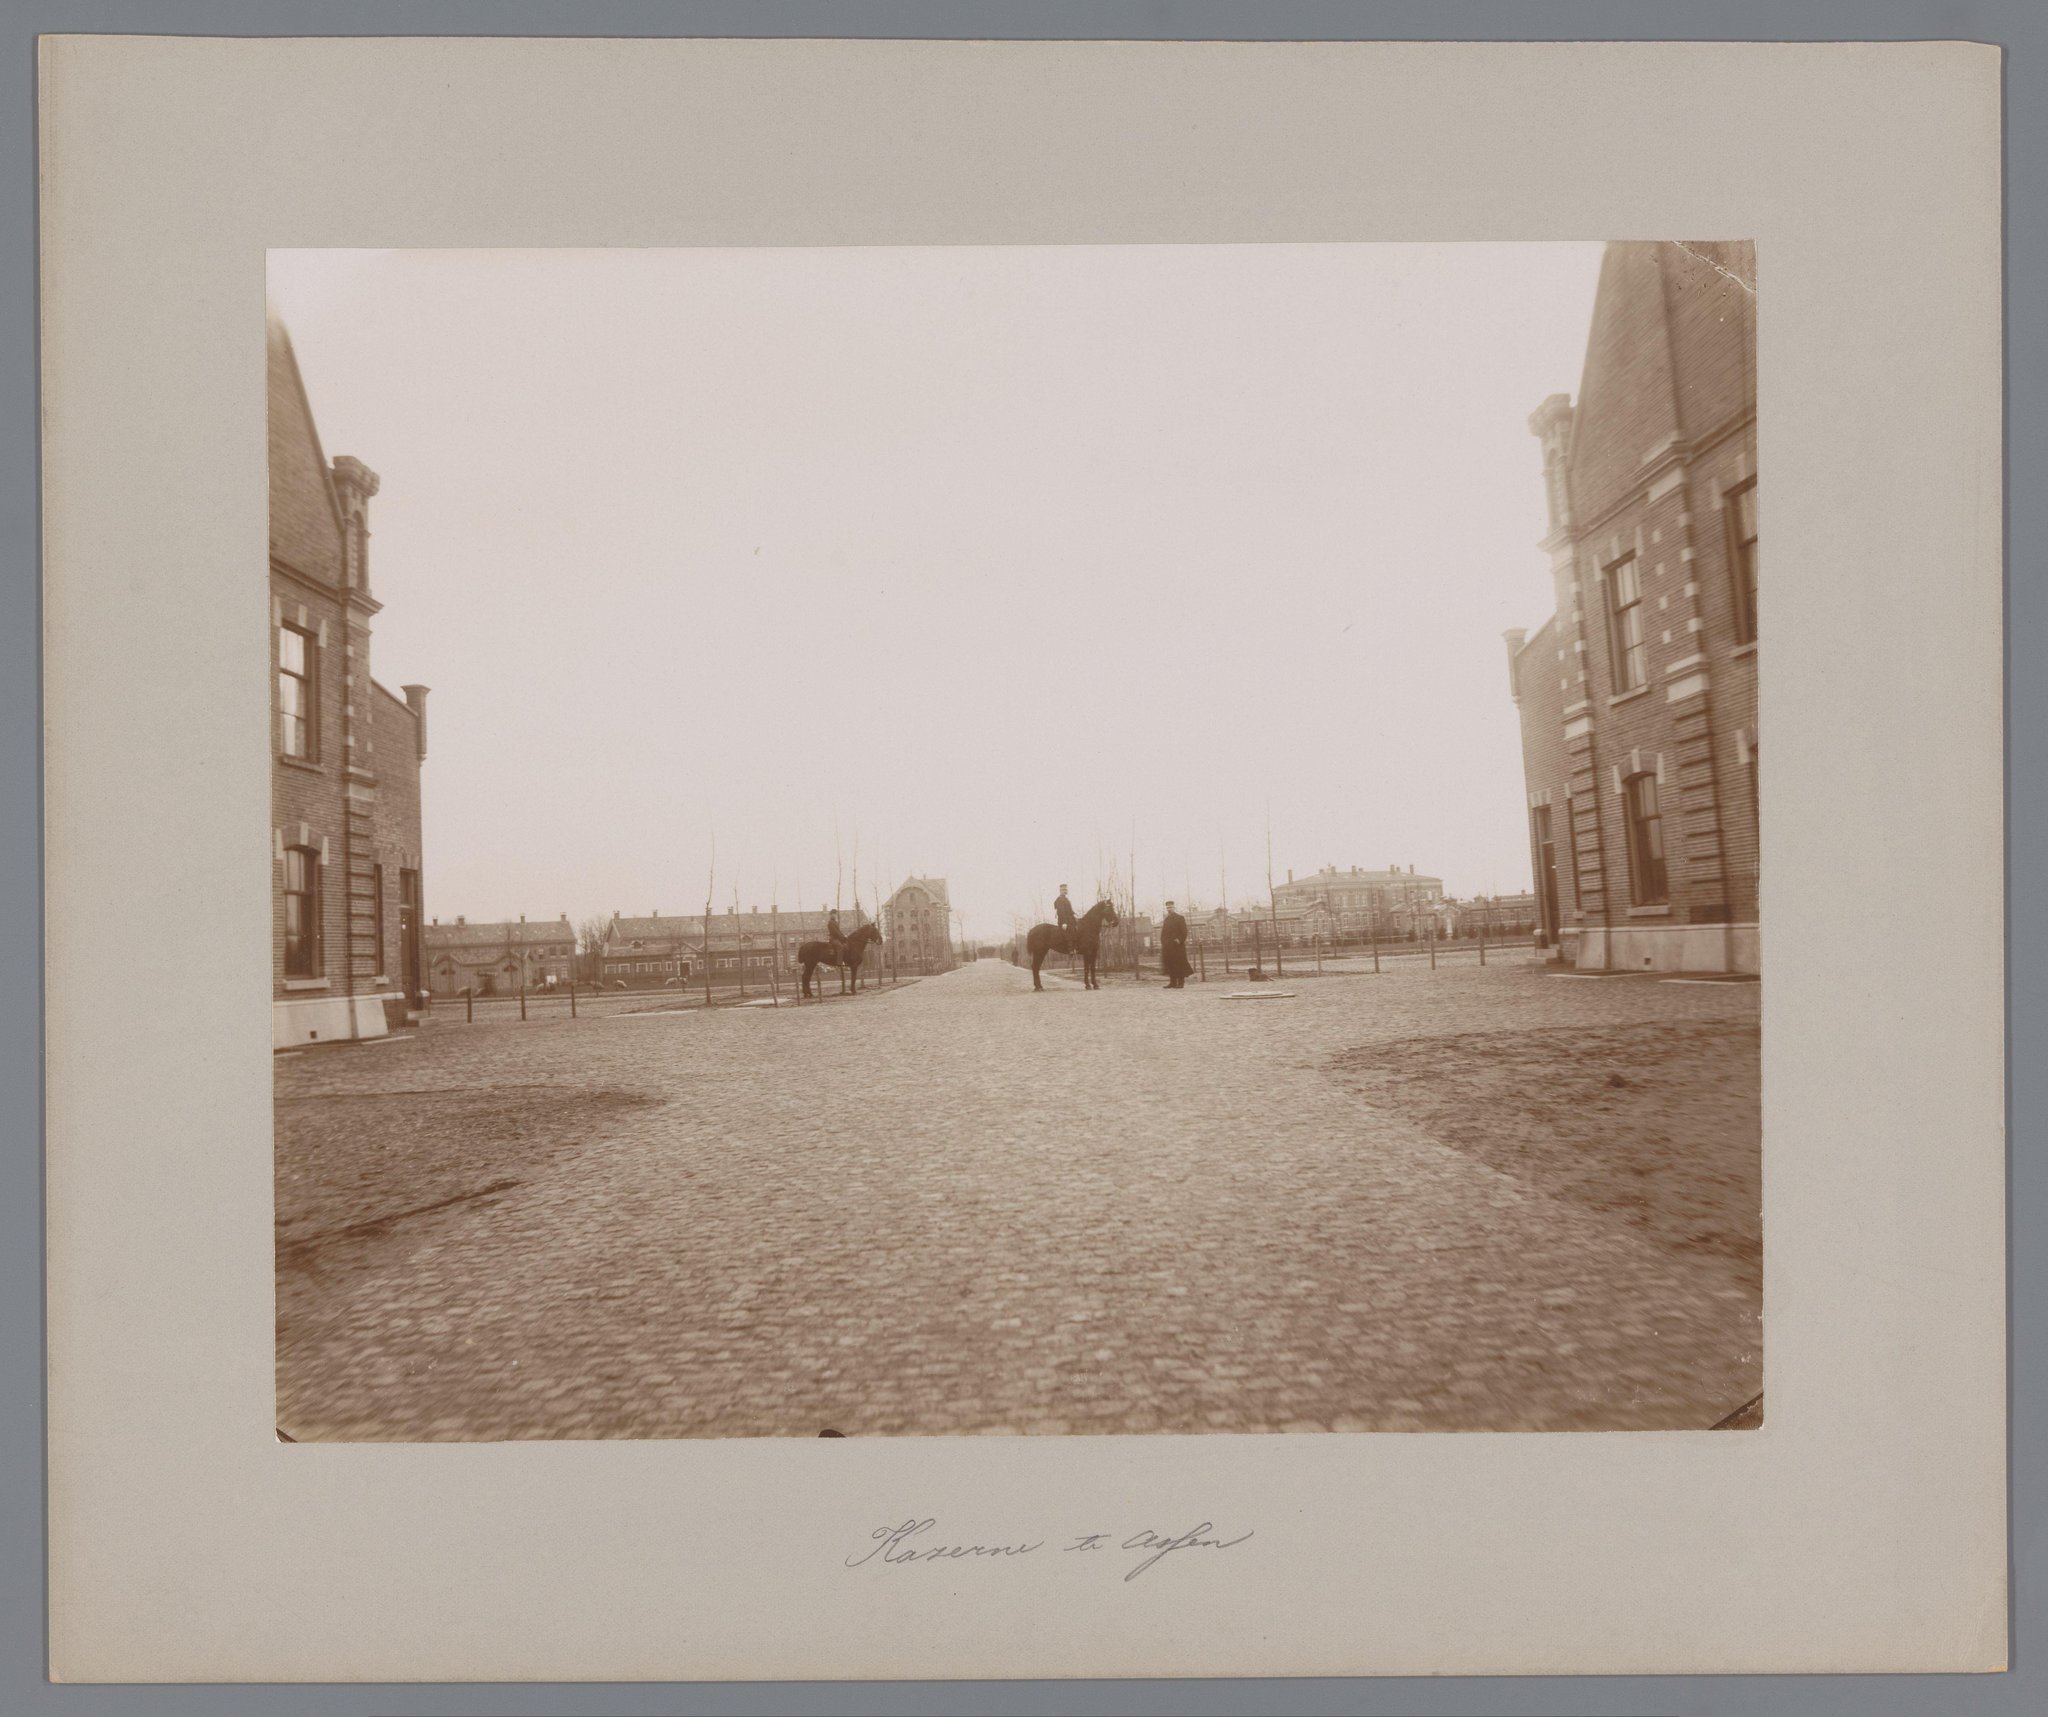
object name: photograph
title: Terrein van de Johan Willem Frisokazerne te Assen met twee ruiters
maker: Anonymous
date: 1892-1920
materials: cardboard, photographic support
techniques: collodion silver print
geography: assen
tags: riding a horse, ass, or mule; rider, horseman, military academy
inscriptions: annotation: ‘Kazerne te Assen’